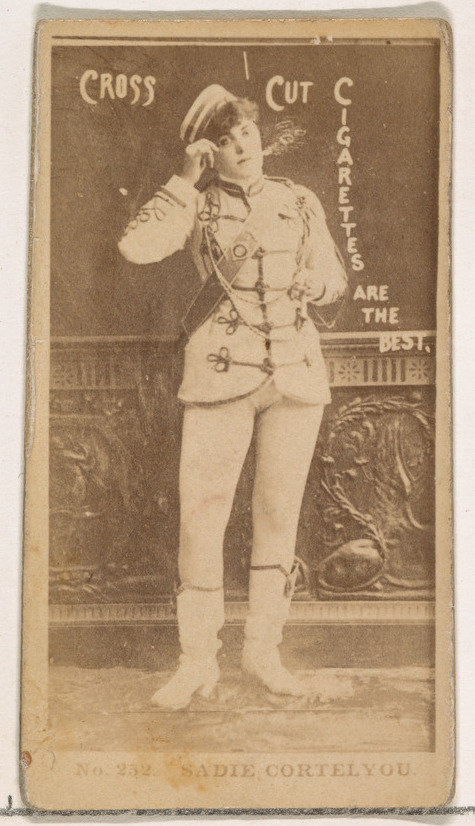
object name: print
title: Card Number 252, Sadie Cortelyou, from the Actors and Actresses series (N145-2) issued by Duke Sons & Co. to promote Cross Cut Cigarettes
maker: w. duke, sons & co.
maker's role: publisher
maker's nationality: american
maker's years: 1870-1920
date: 1880-1889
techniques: albumen silver print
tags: portraits,women,actresses